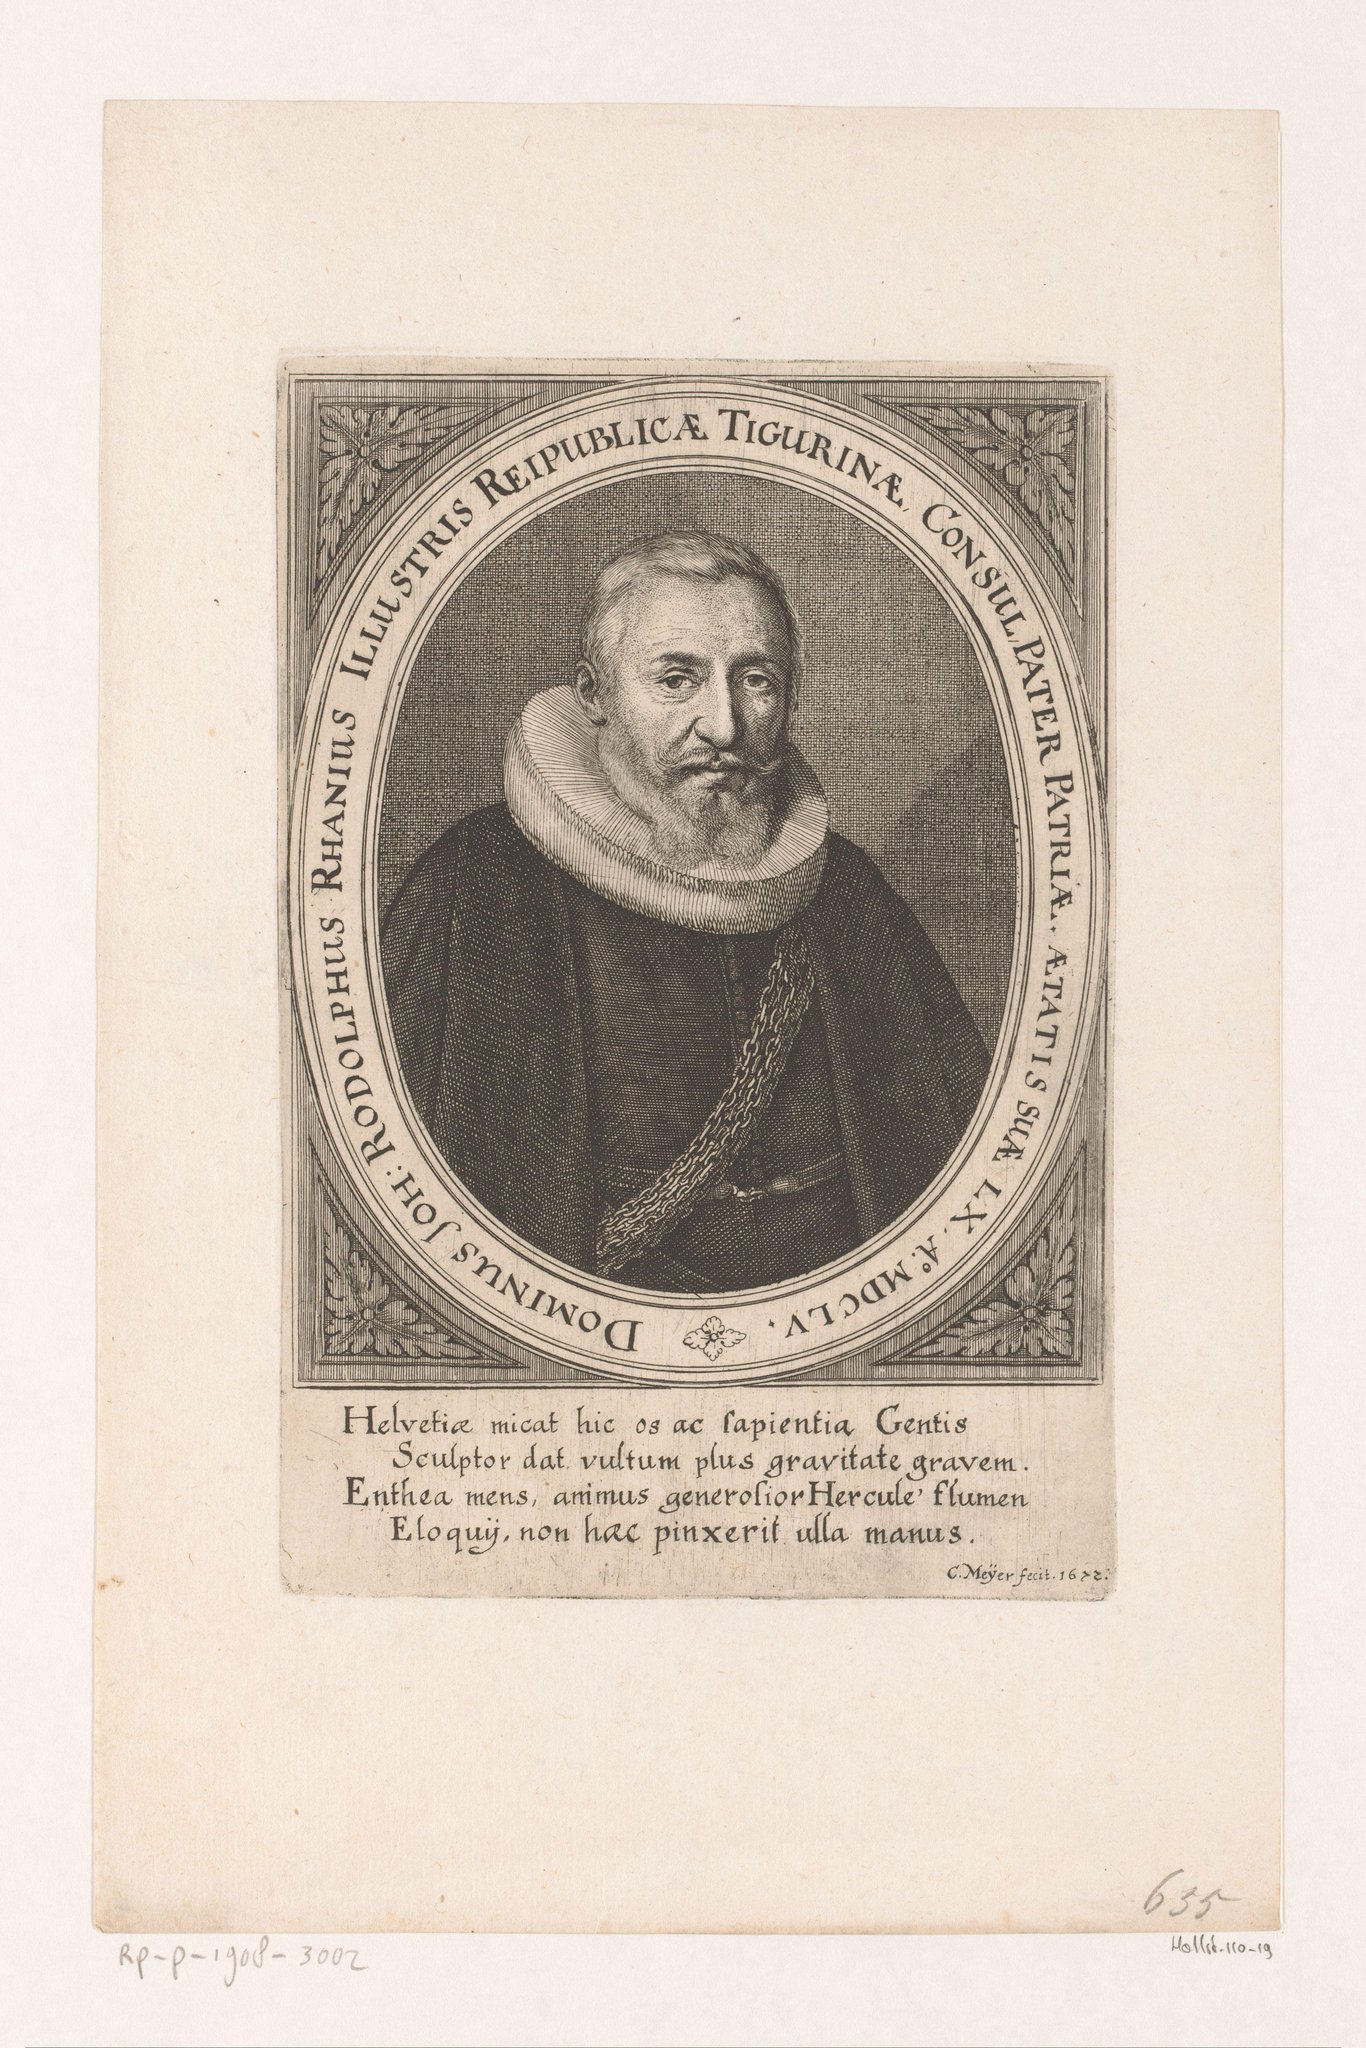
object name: print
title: Portretten van burgemeesters van Zürich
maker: conrad meyer (i)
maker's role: painter, print maker, publisher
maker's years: 1618-1689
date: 1672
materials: paper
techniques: engraving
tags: mayor, burgomaster, other non-personal regalia, e.g. mayor chain, historical persons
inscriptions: collector's mark: Lugt 2228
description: Onderdeel van een serie van 67(?) portretten van burgemeesters van Zürich. Zie Hollstein German 110, 1-26.